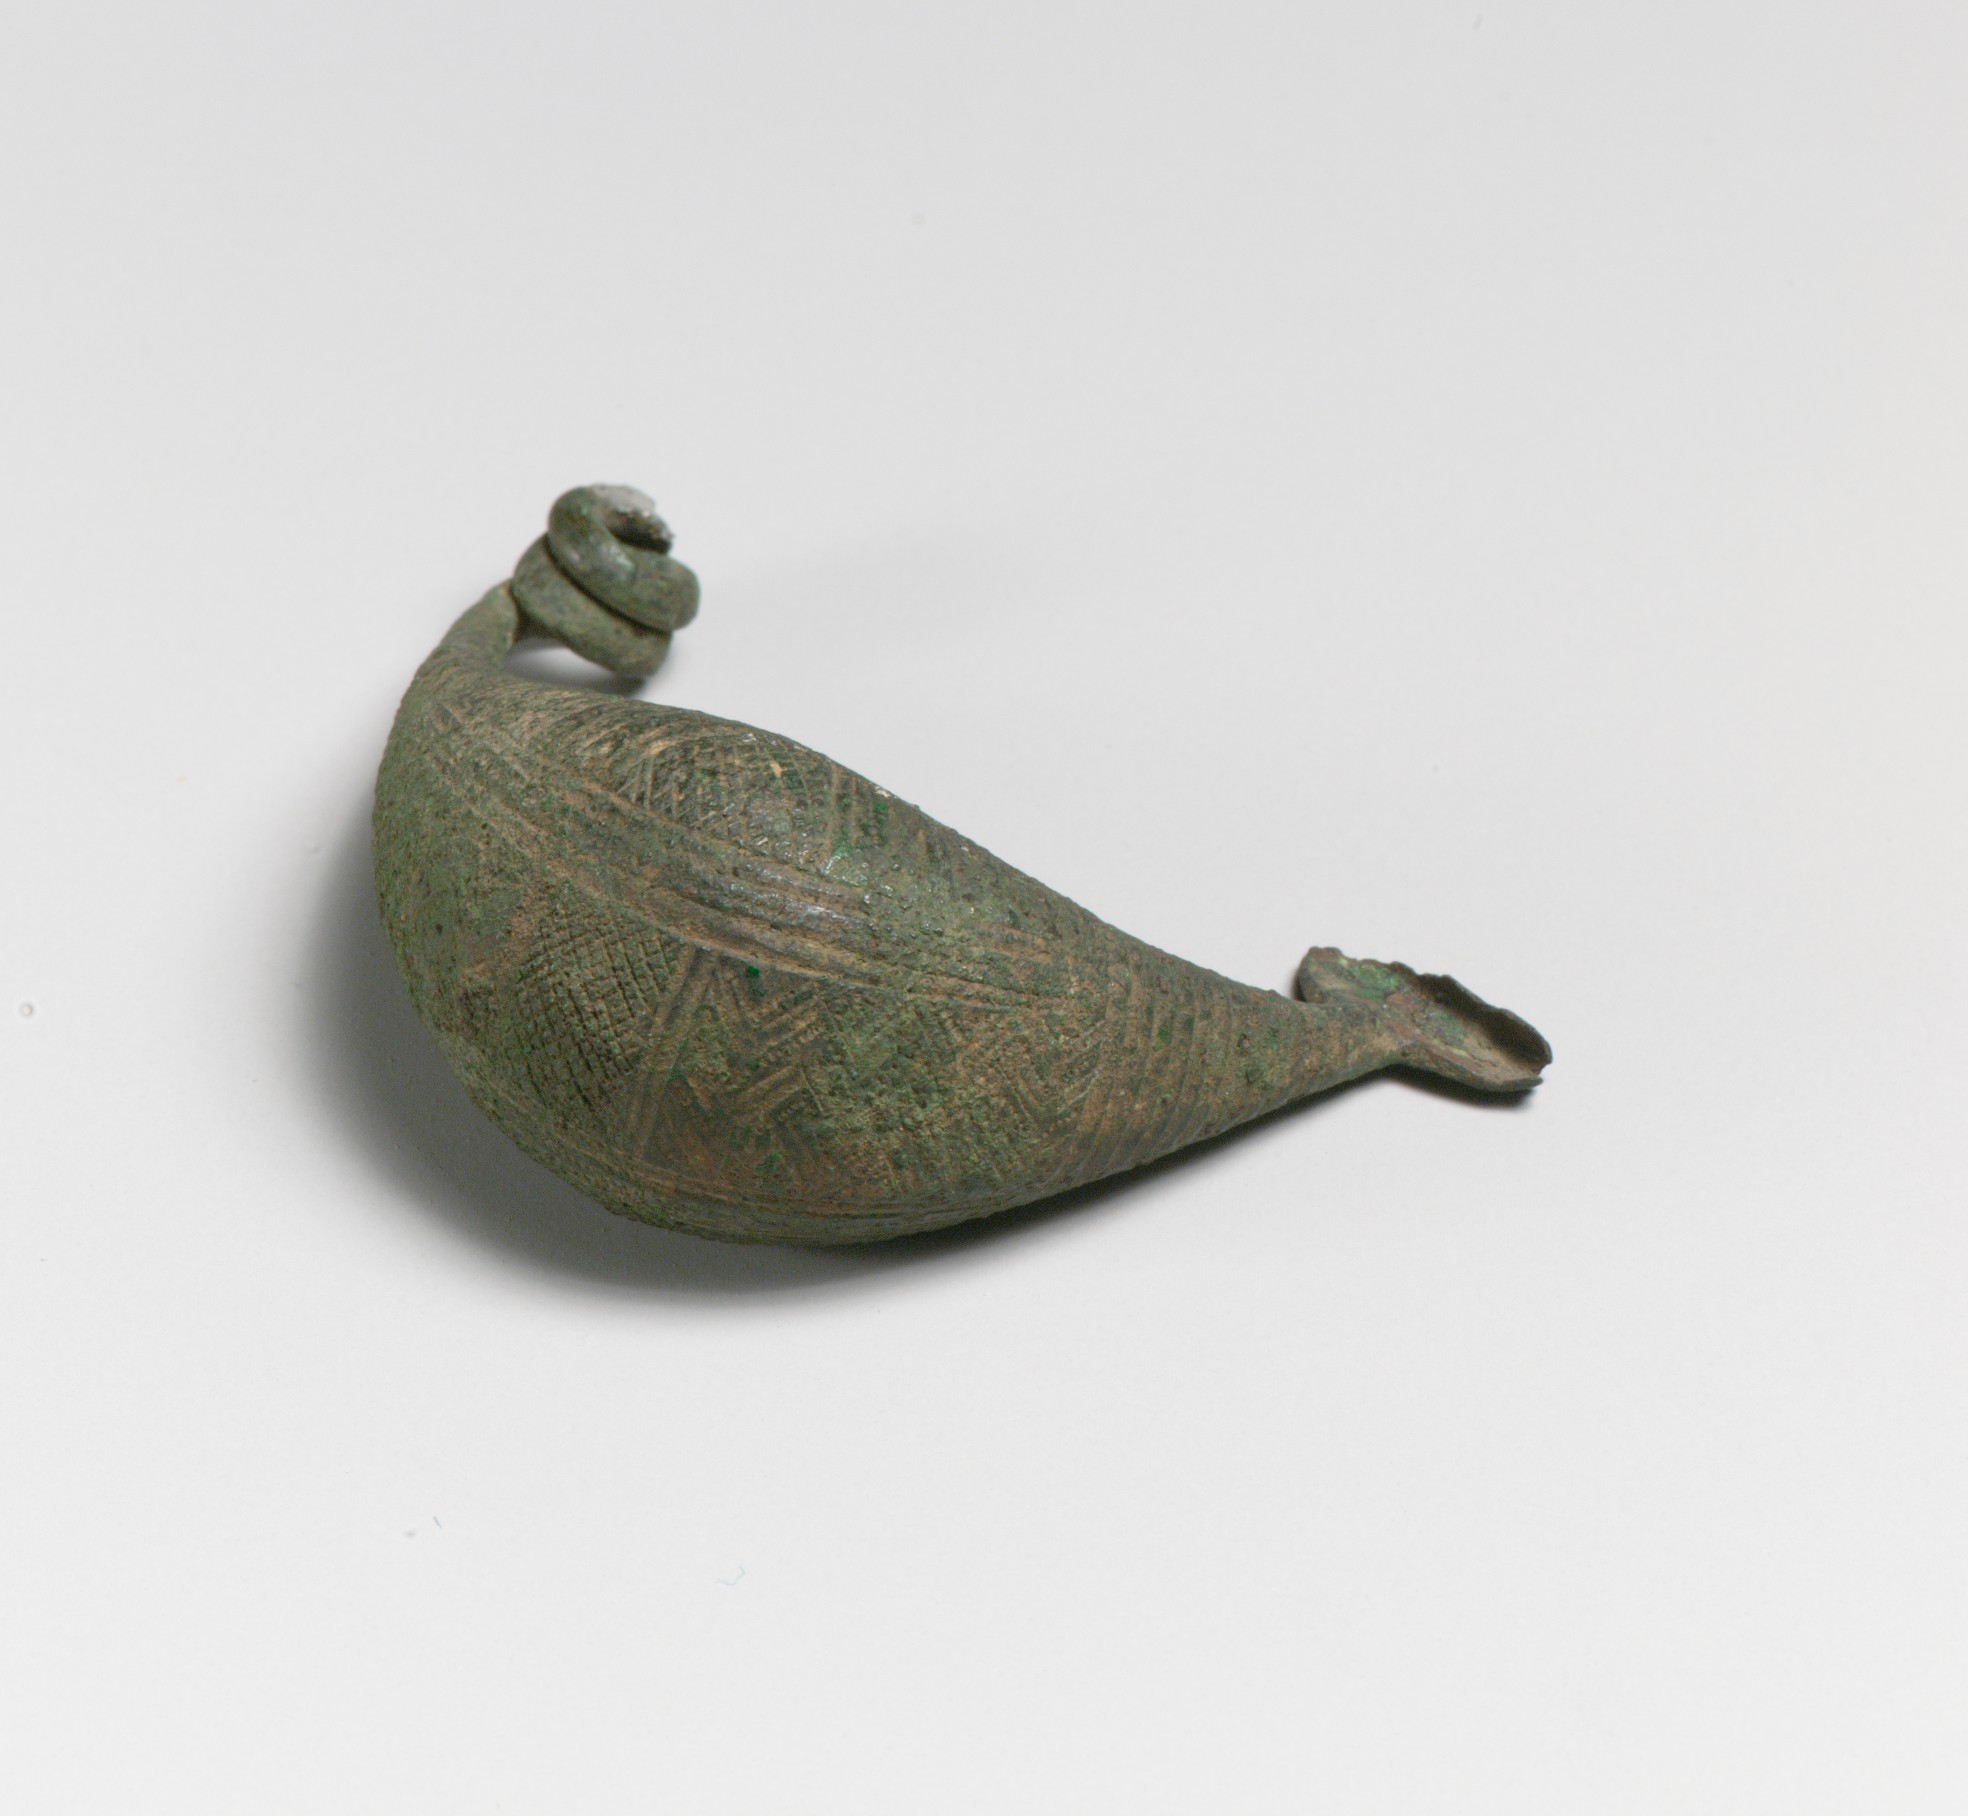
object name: fibula, boat shaped type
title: Fibula, boat-shaped type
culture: italic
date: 900-701 BCE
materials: bronze